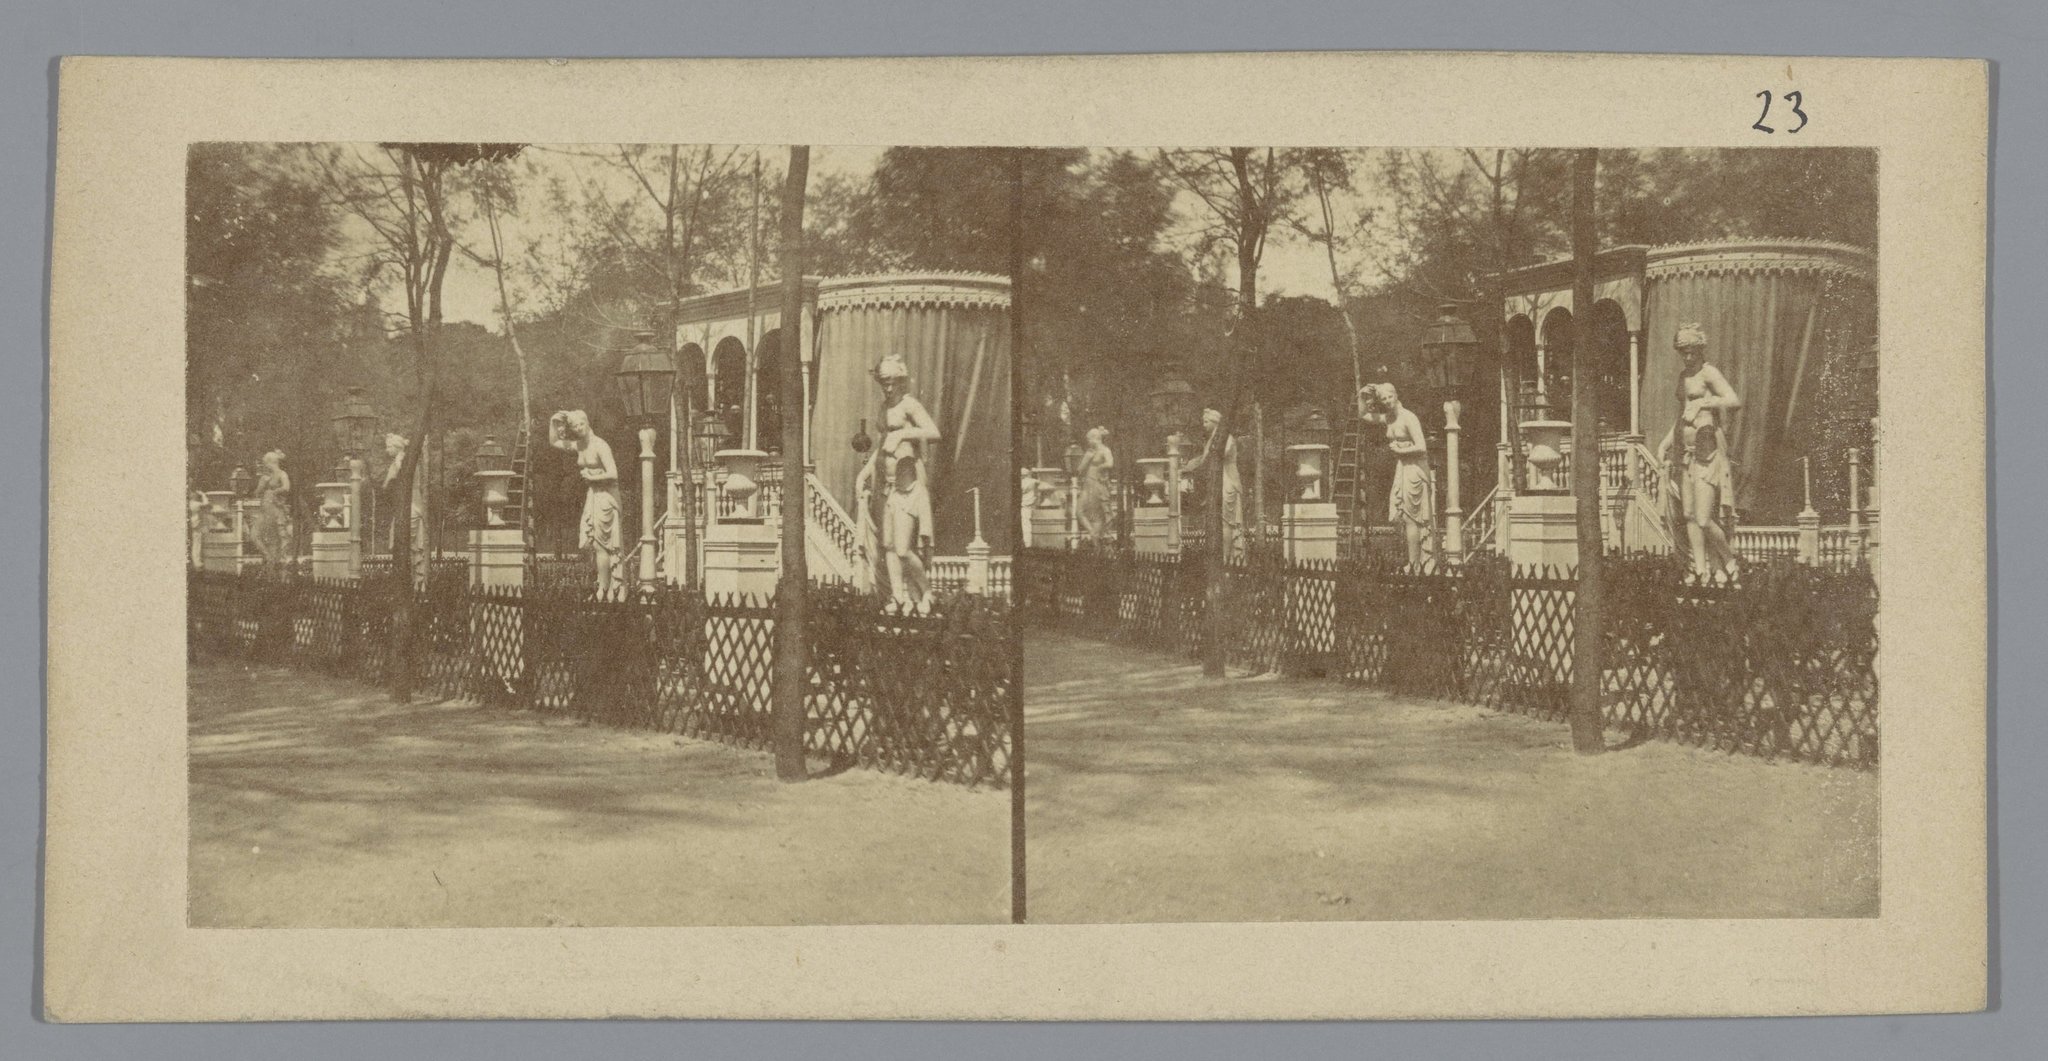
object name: stereograph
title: Cafee chantant, Champs Elysees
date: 1851-1880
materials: cardboard, paper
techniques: albumen print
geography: paris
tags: tea garden, garden restaurant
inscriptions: retailer's mark: ‘222, rue de Rivoli/ en face le Jardin des Tuileries./ Lecocq-Frêne/ Estampes Photographies/ Plans et Guides pour Voyageurs/ Vues pr Stéreoscopes.’, number: ‘23’